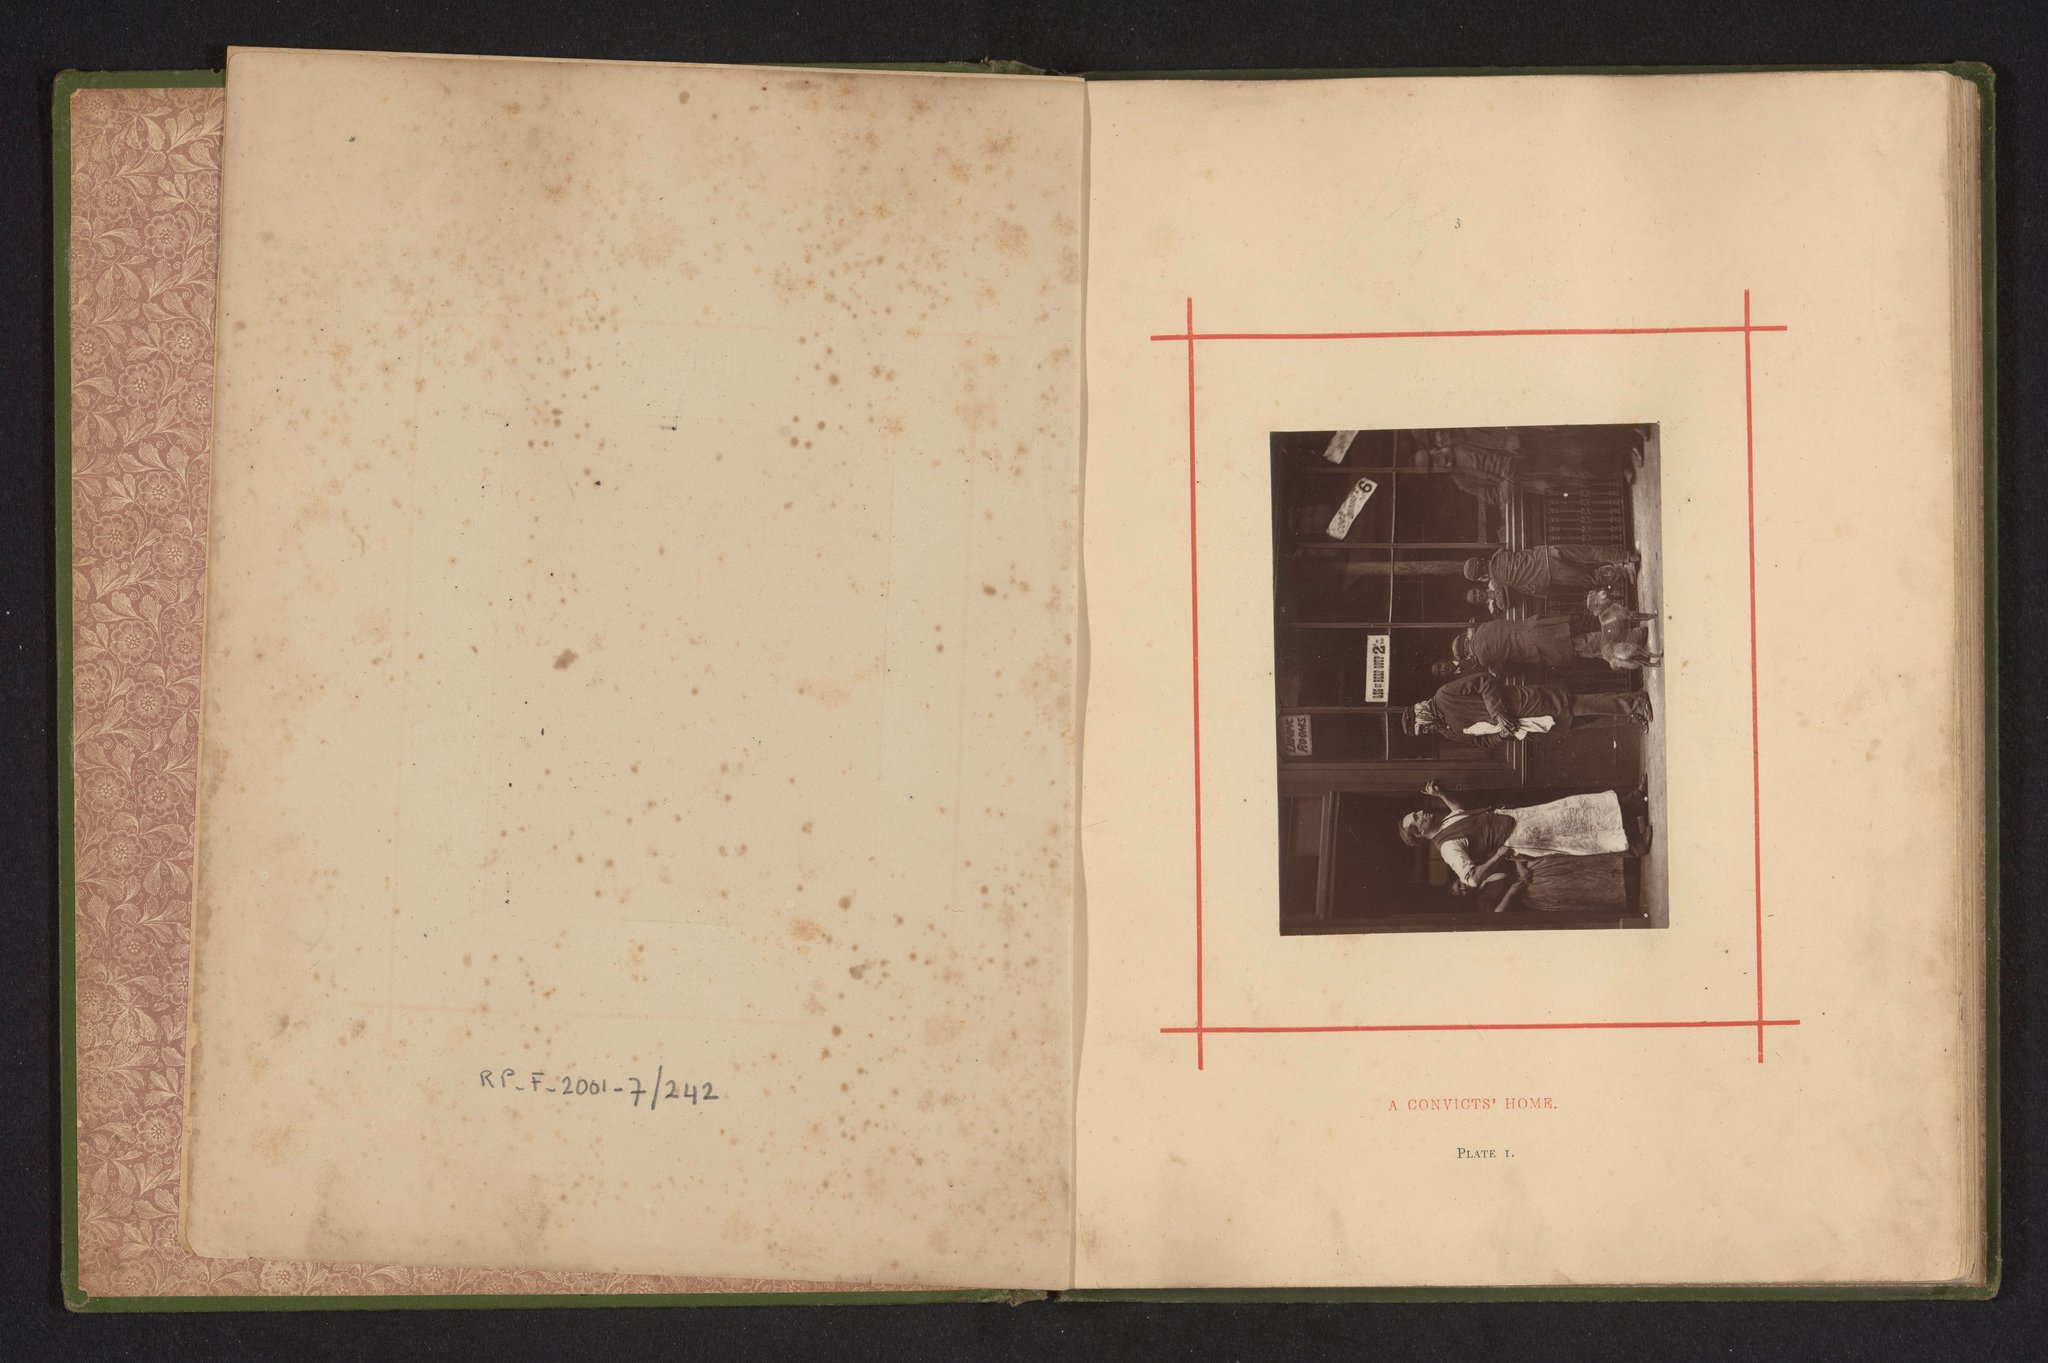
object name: photomechanical print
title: A convicts' home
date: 1871-1881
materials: paper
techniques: woodburytype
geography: london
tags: soup-kitchen, cook-shop, façade (of house or building)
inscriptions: number: ‘Plate 1.’